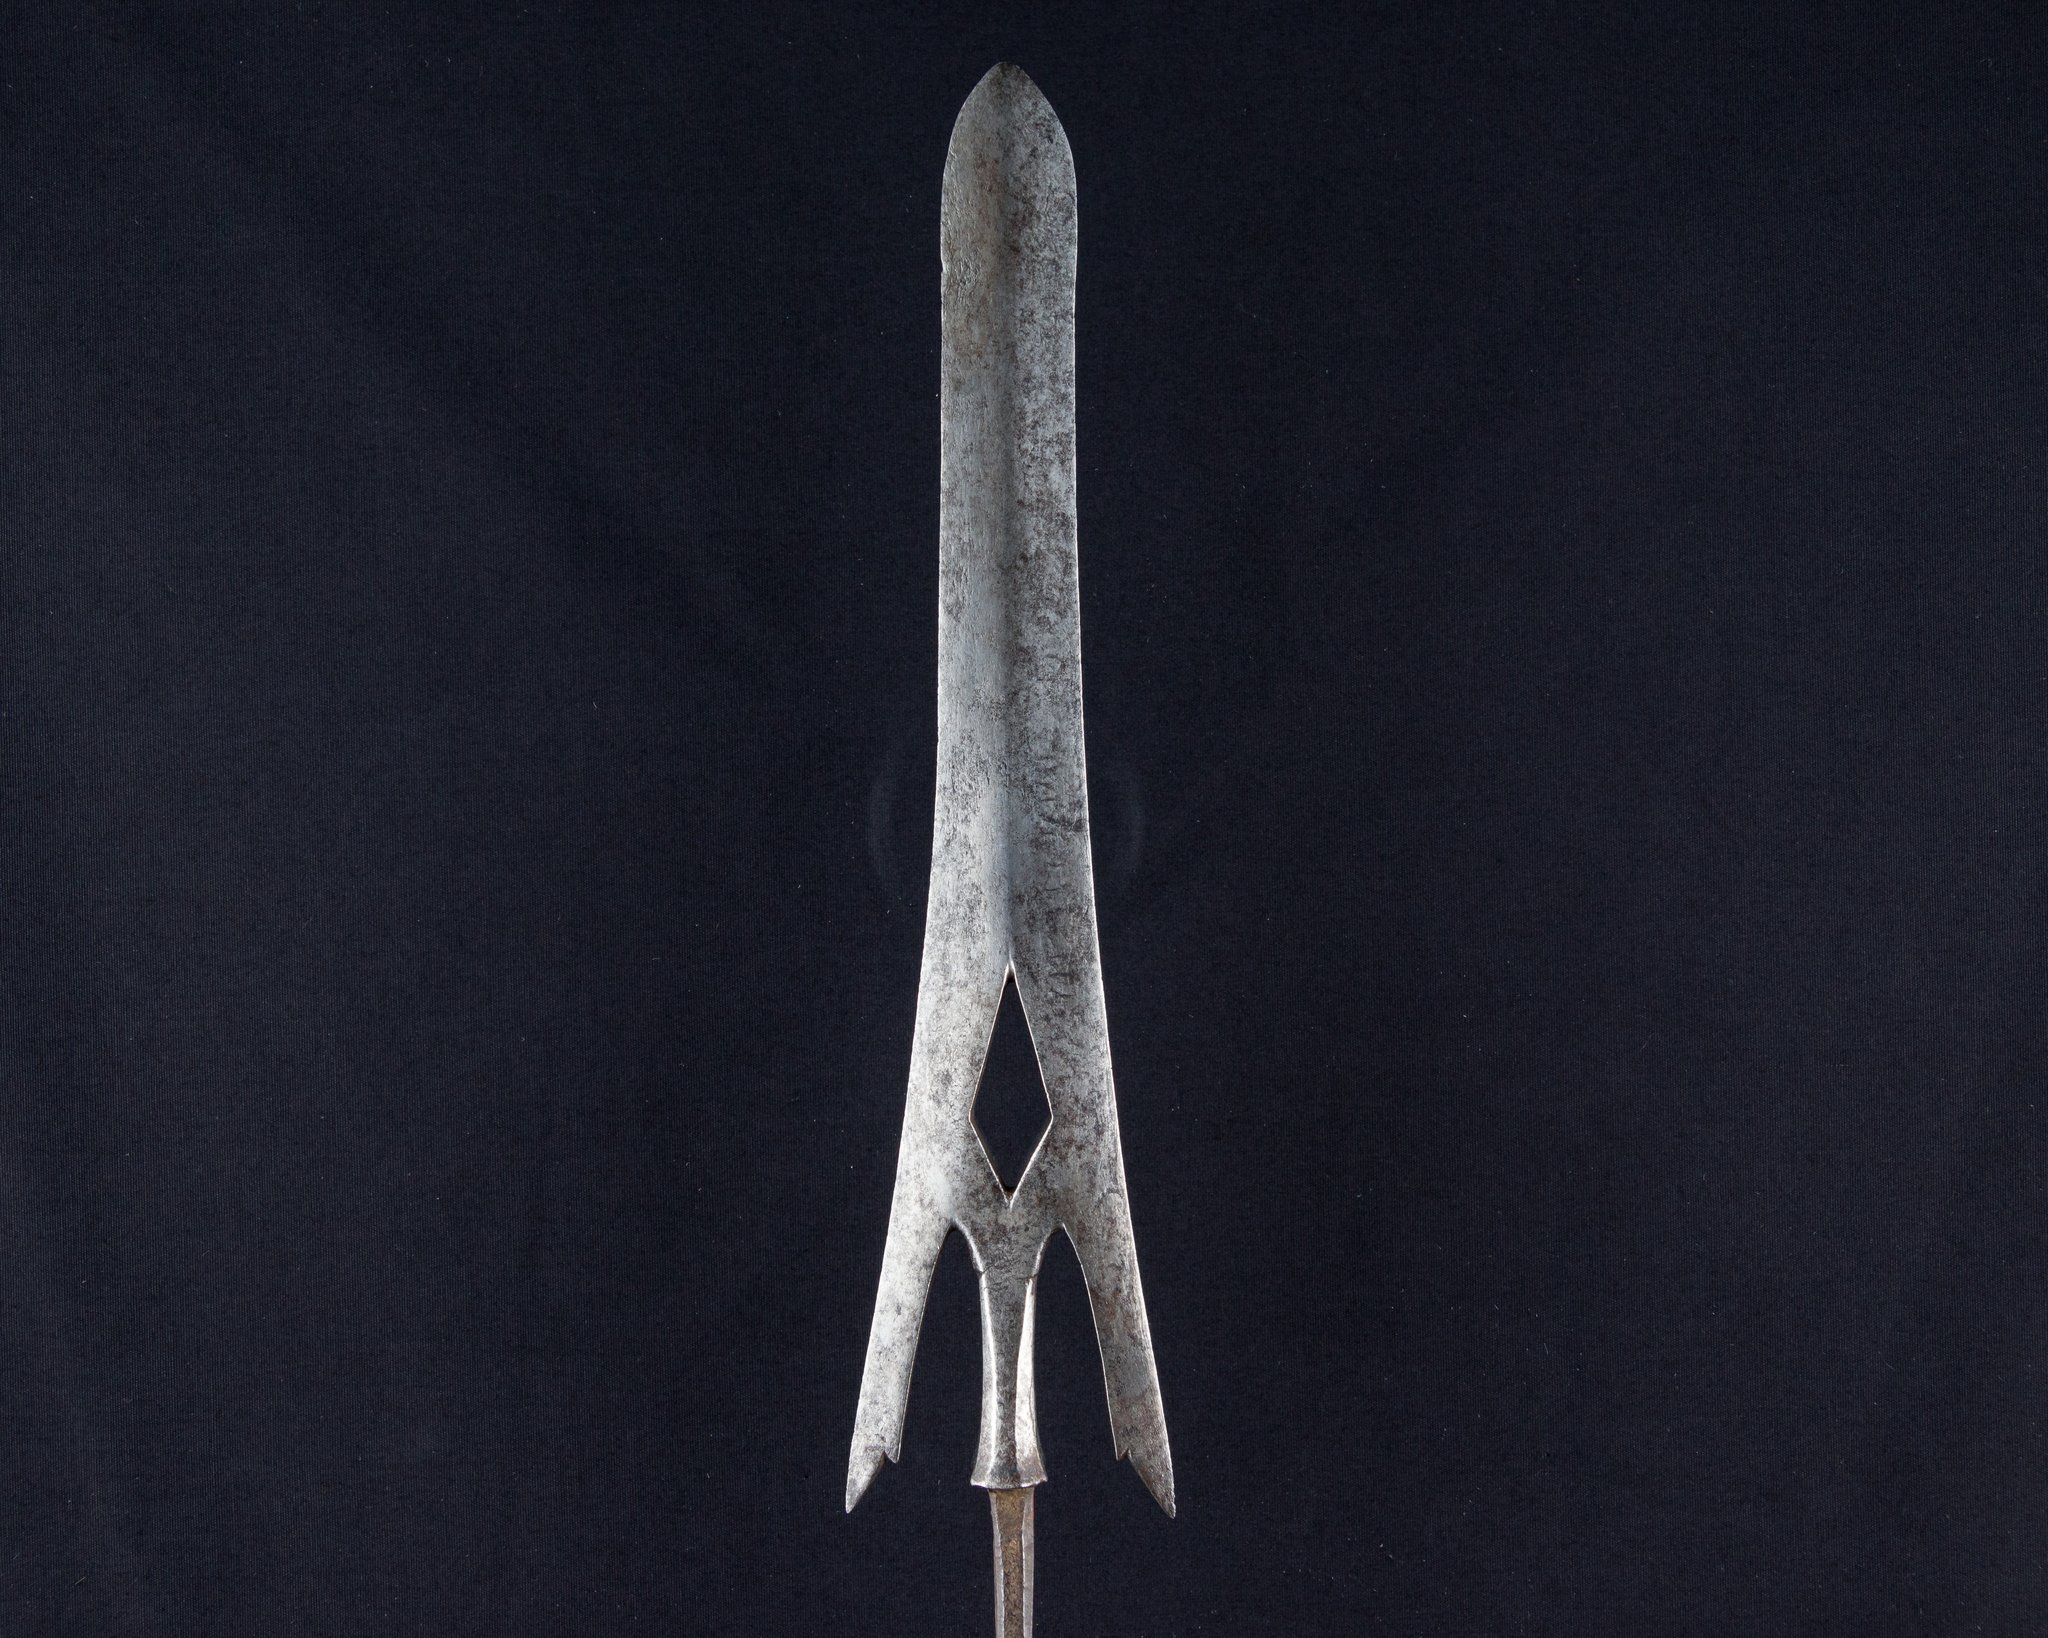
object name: arrowhead i yanone i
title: Arrowhead (Yanone)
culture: japanese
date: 1701-1800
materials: steel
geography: japan